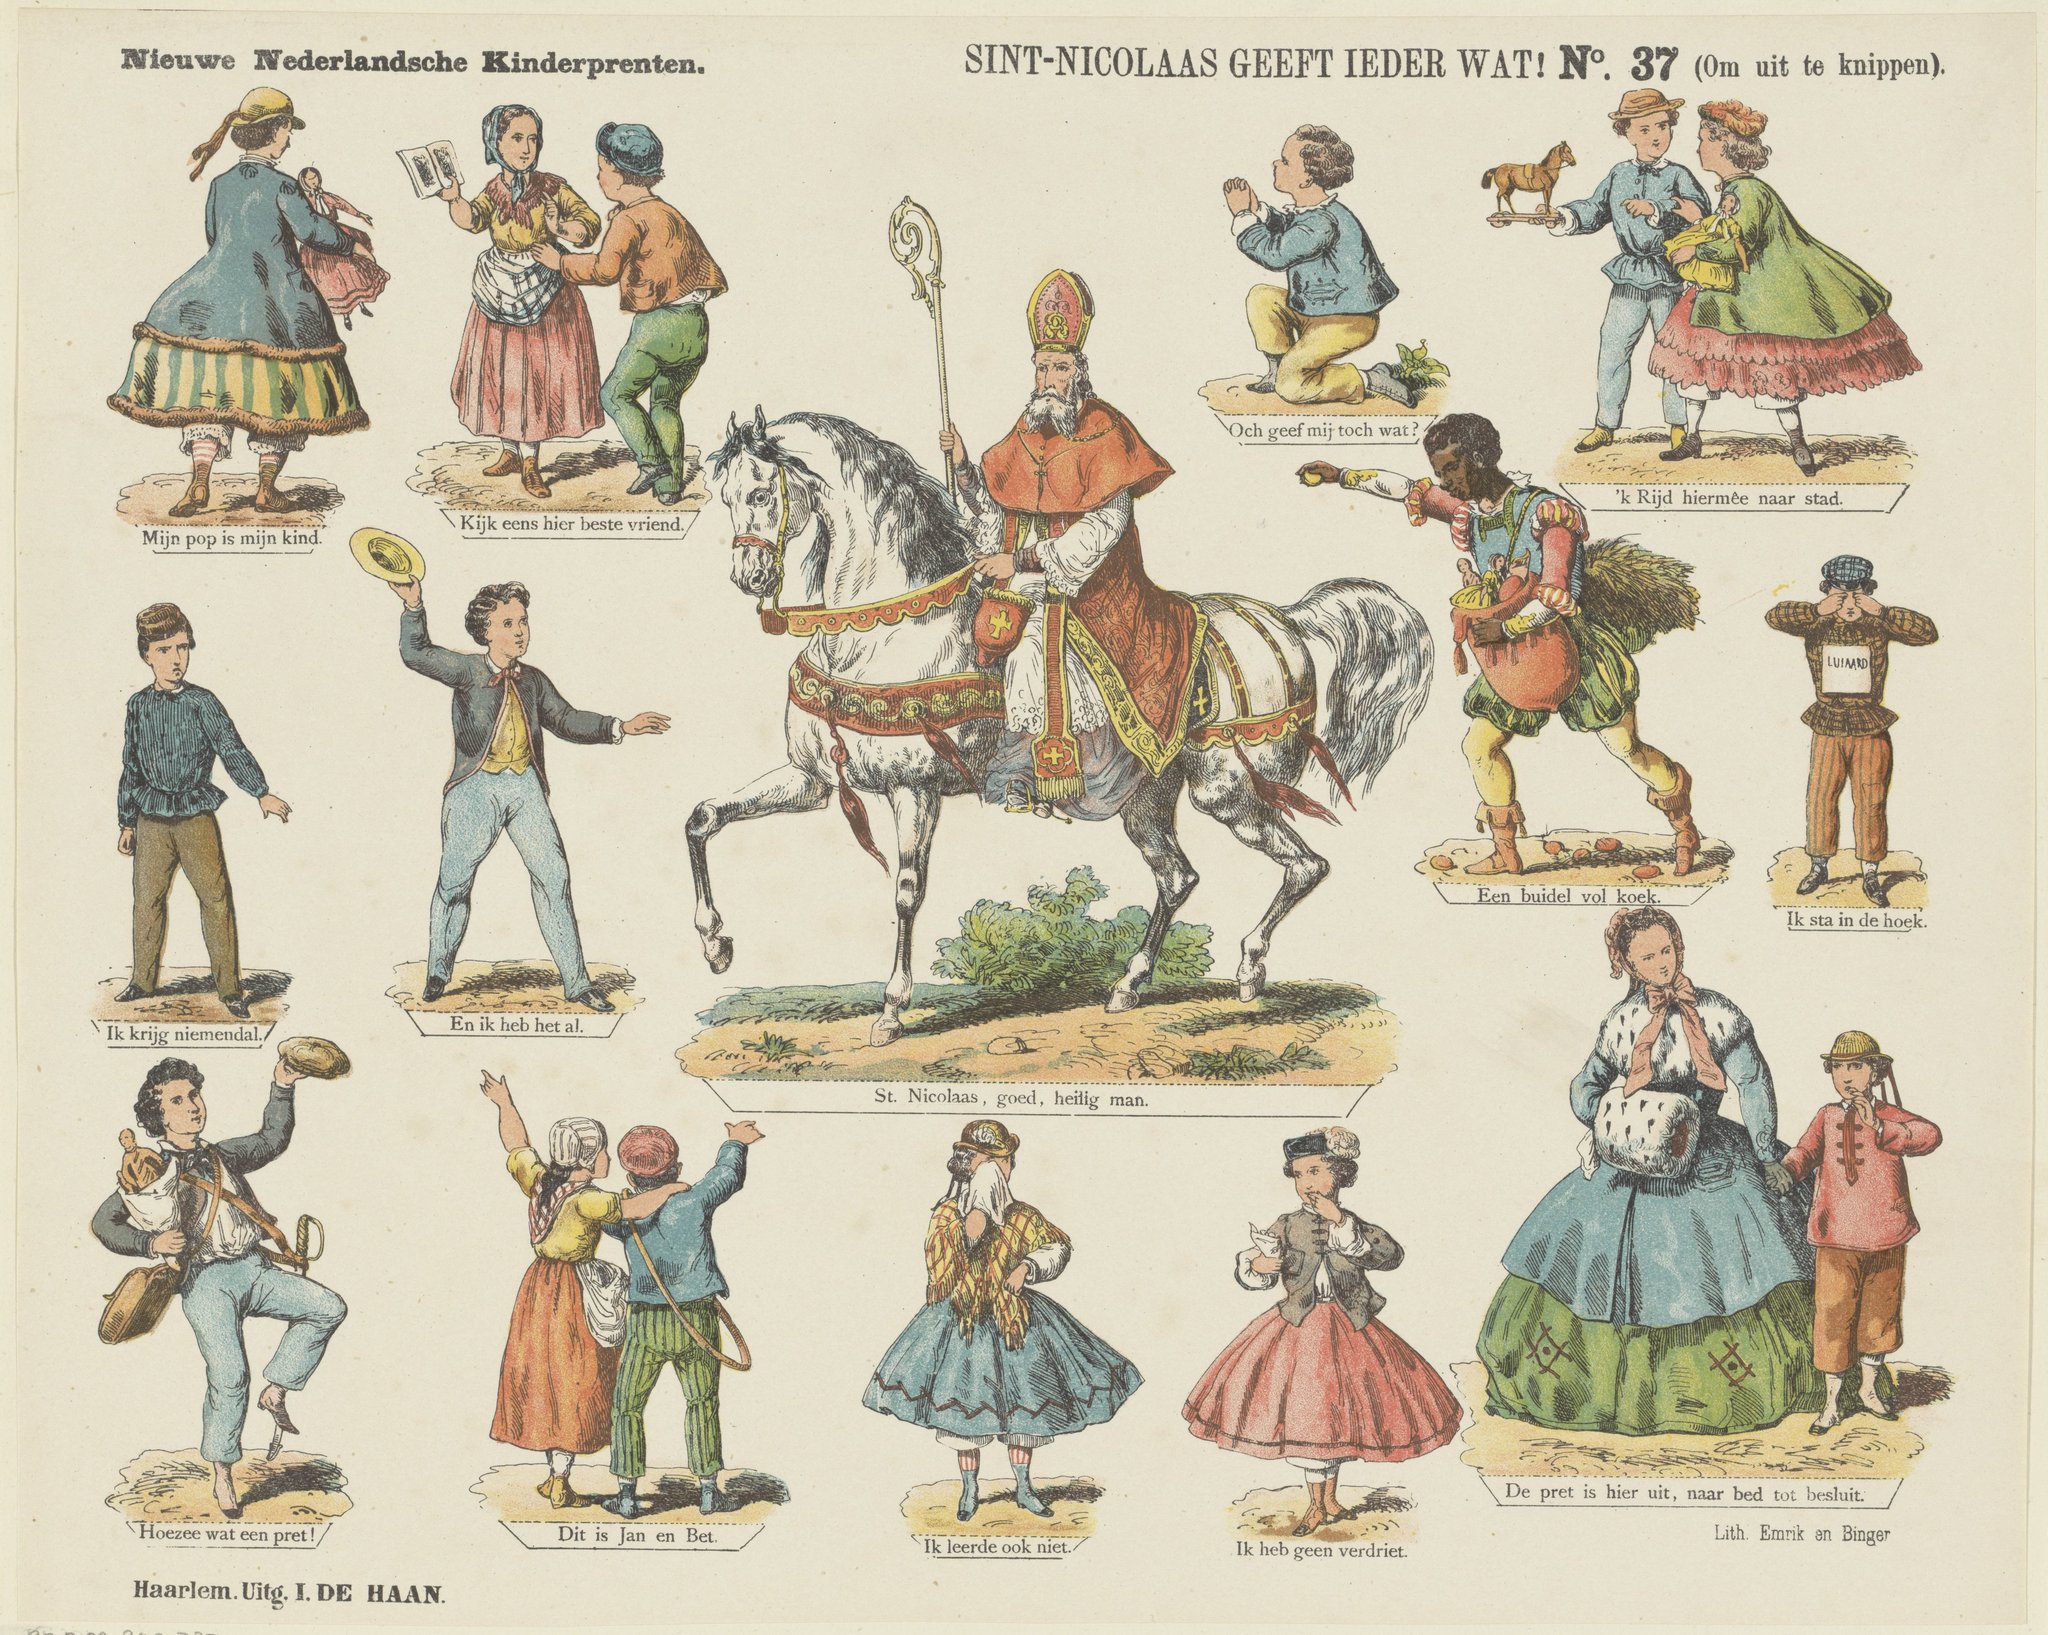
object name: popular print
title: St Nicholas Gives Everyone Something!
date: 1875-1903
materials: paper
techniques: lithograph, letterpress printing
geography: haarlem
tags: the bishop nicholas of myra (or bari); possible attributes: anchor, boat, three golden balls (on a book), three purses, three children in a tub, three maidens, festivities on st. nicholas (eve) (december 5)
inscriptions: collector's mark: Lugt 2760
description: With the help of this print, any child could cut out and assemble his or her own Saint Nicholas parade. The title is misleading, for children who have been lazy or naughty certainly continue to be left empty-handed. But no corporal punishment is meted out, for Pete is busy handing out presents.